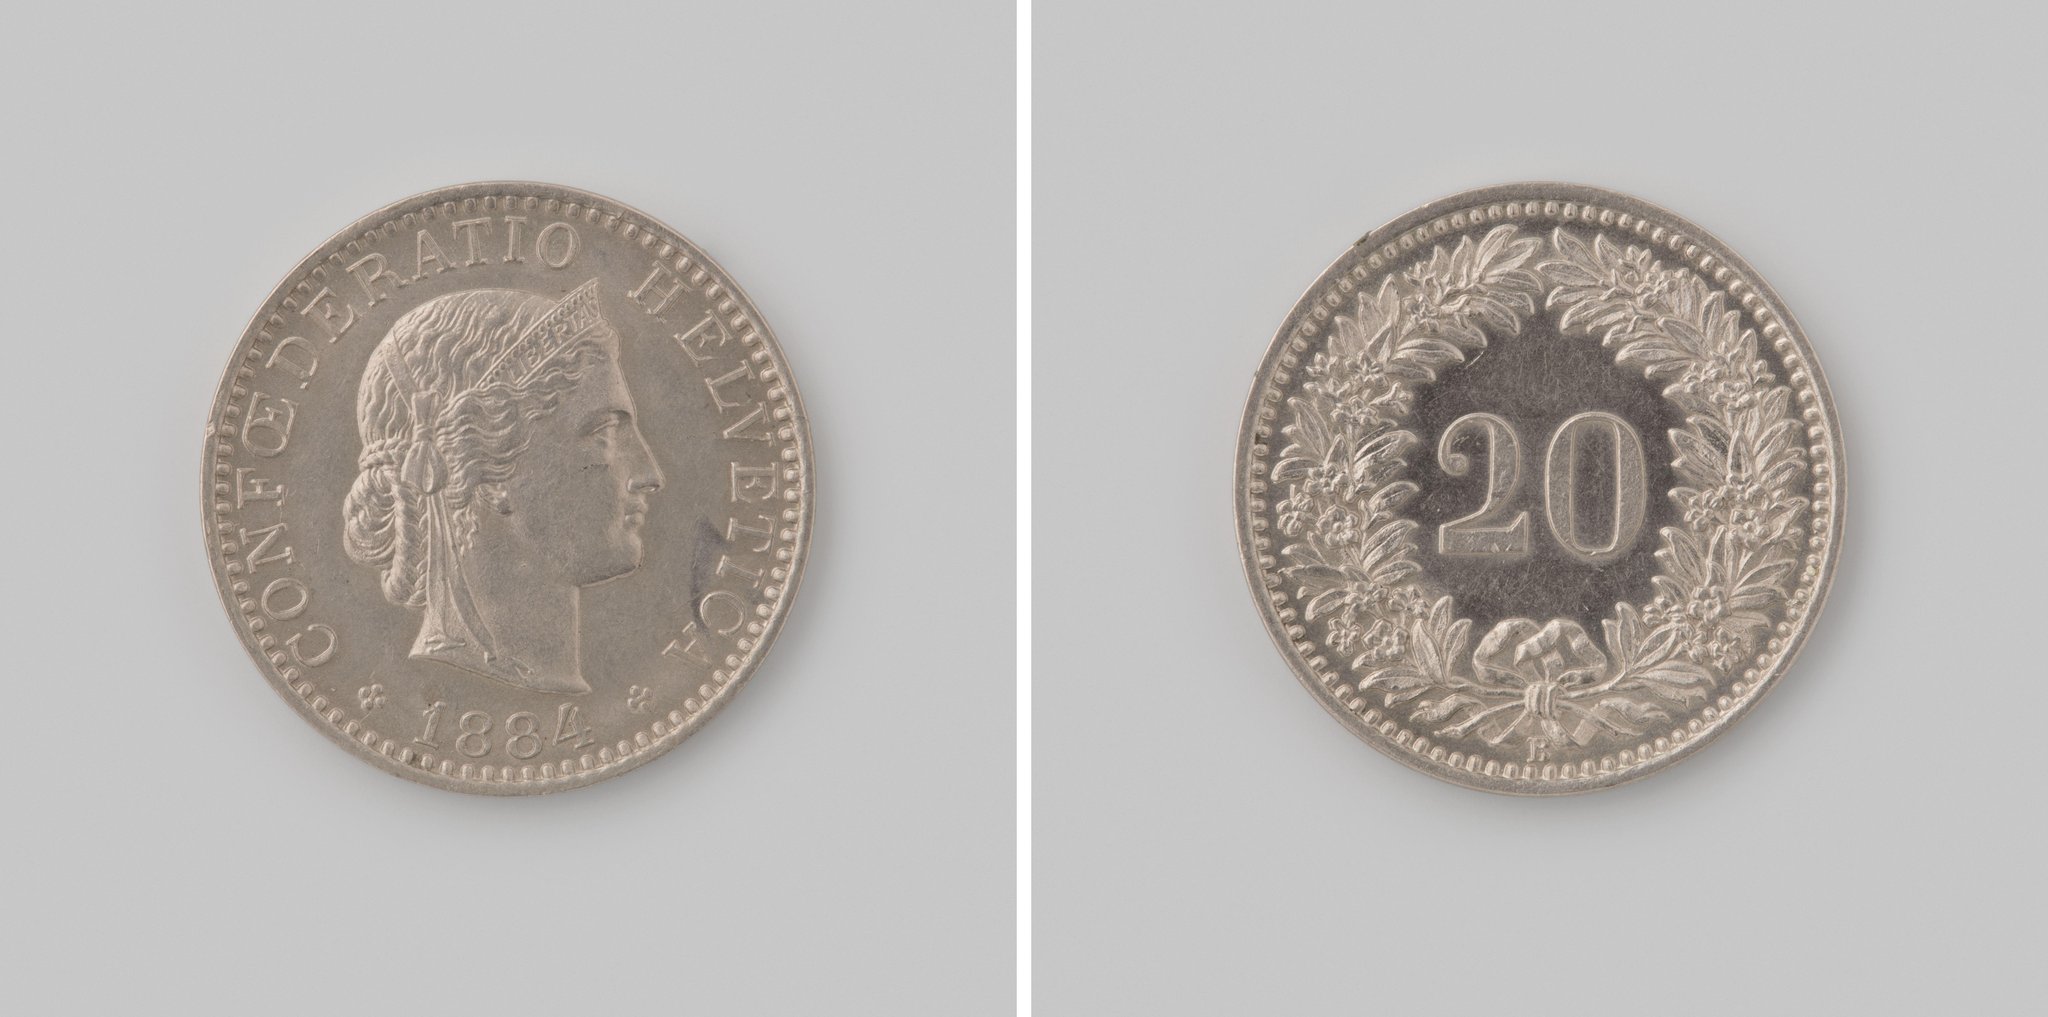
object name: coin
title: 20 centimes uit Zwitserland,1884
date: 1884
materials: nickel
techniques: striking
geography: bern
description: Nikkelen munt. Voorzijde: hoofd van vrouw met haarband, waarop aanduiding: libertas naa rechts. Jaartal onderaan. Keerzijde: binnen twee samengebonden takken in een regel waarde-aanduiding. Onderaan letter B [=Bern]. Gladde rand.